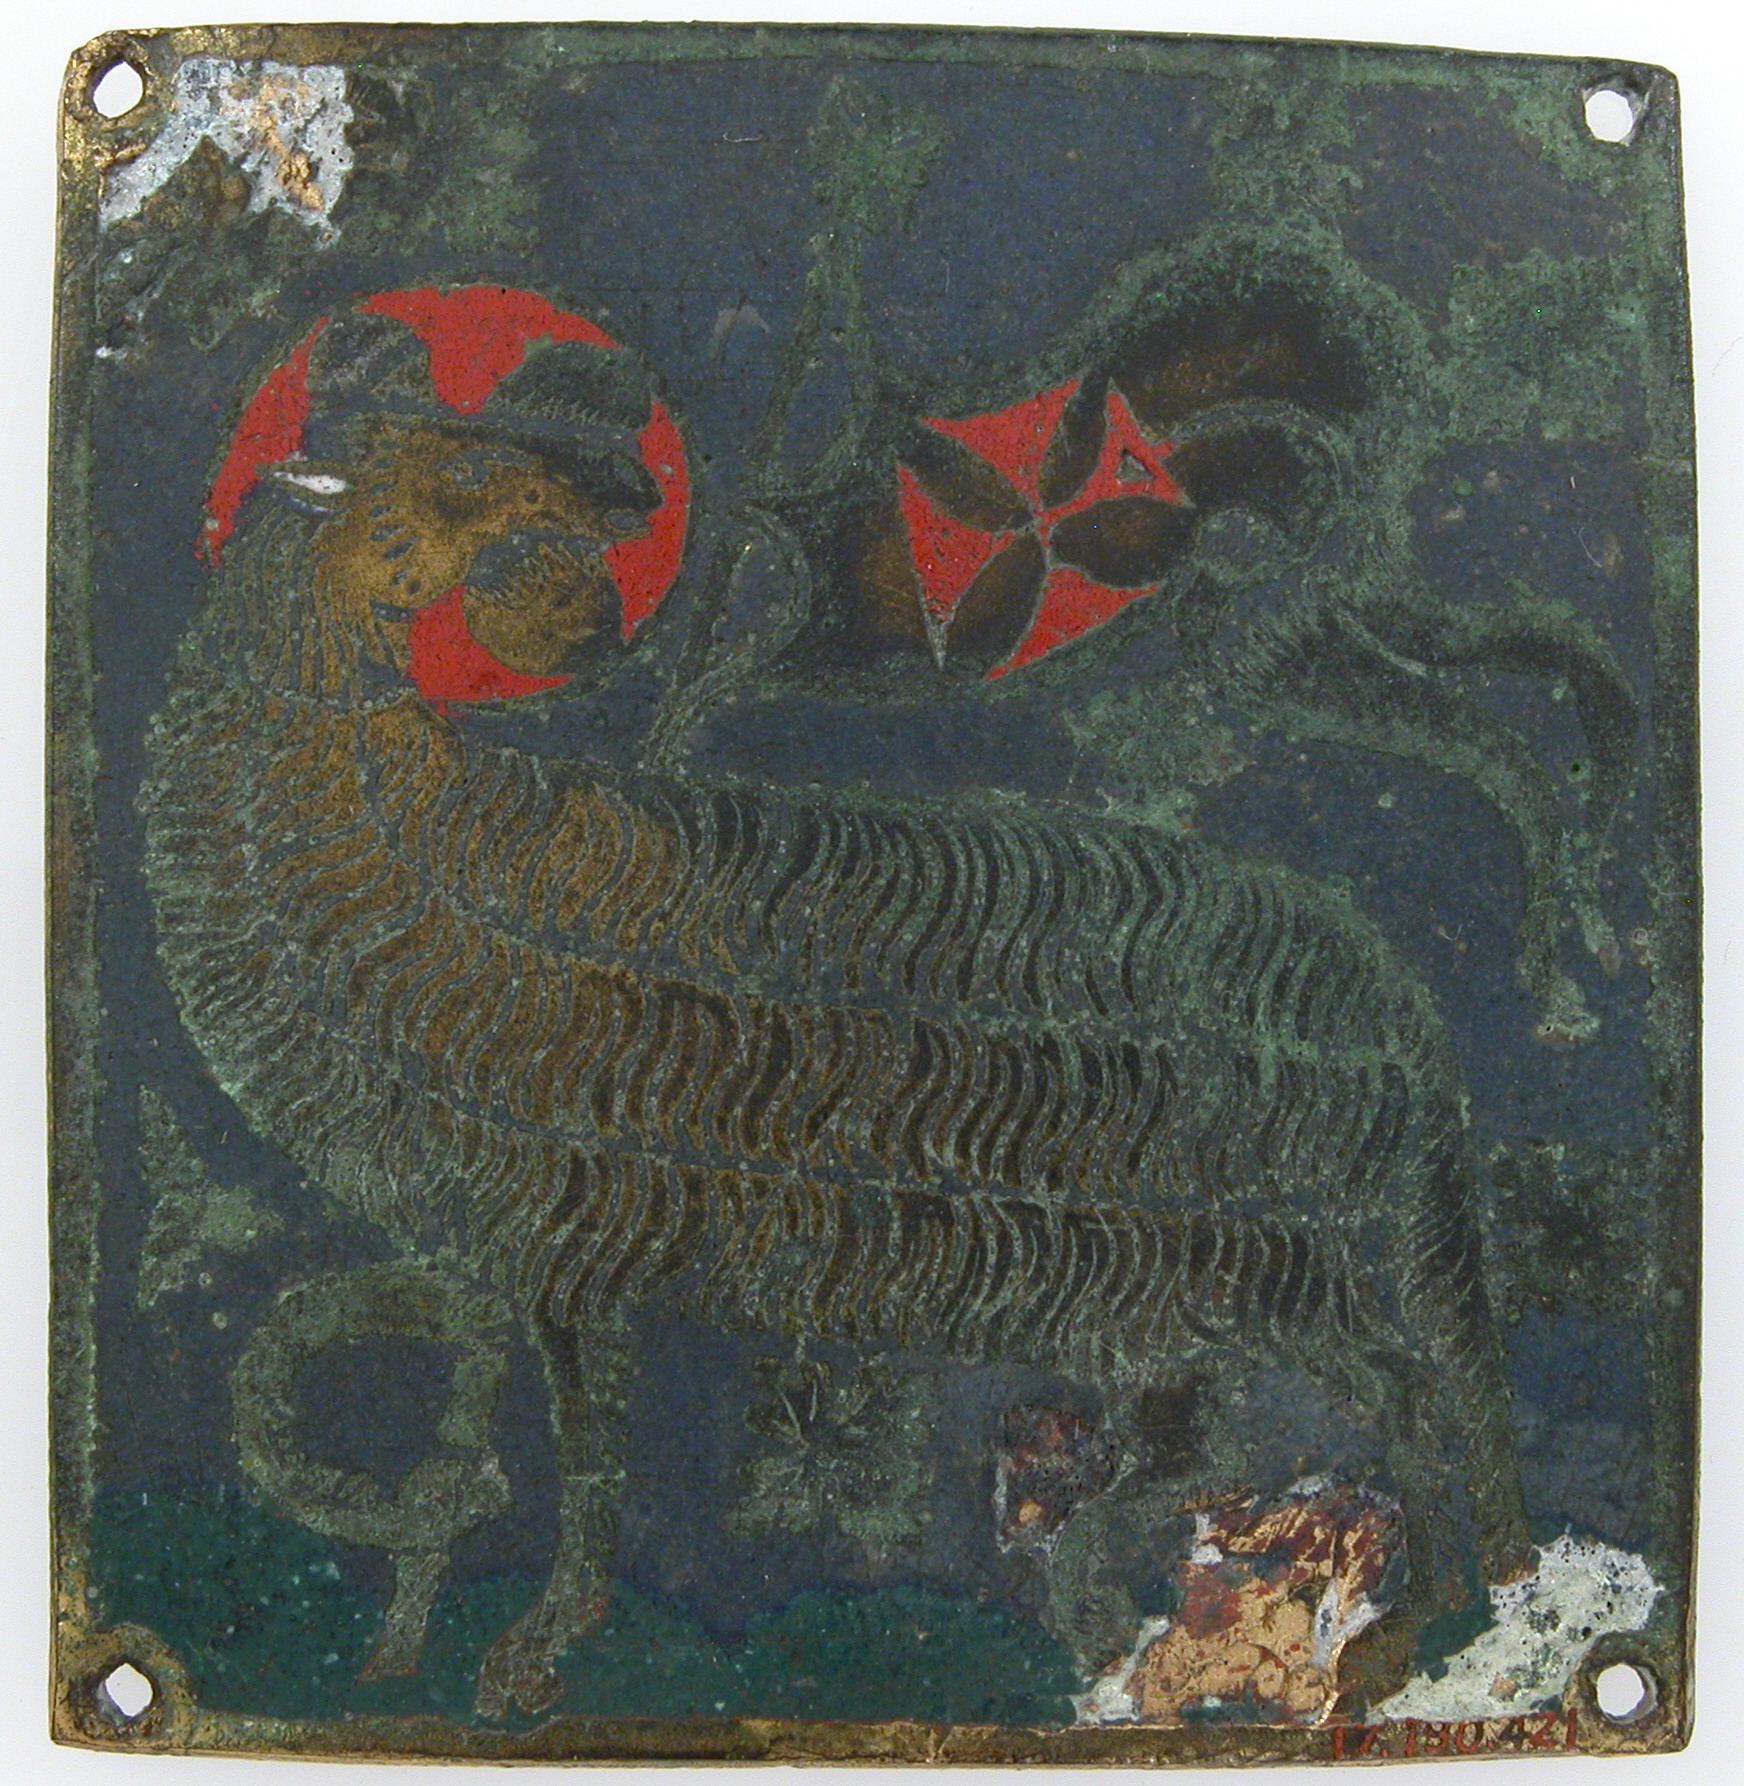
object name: plaque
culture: german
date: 1101-1300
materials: copper, enamel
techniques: enamel